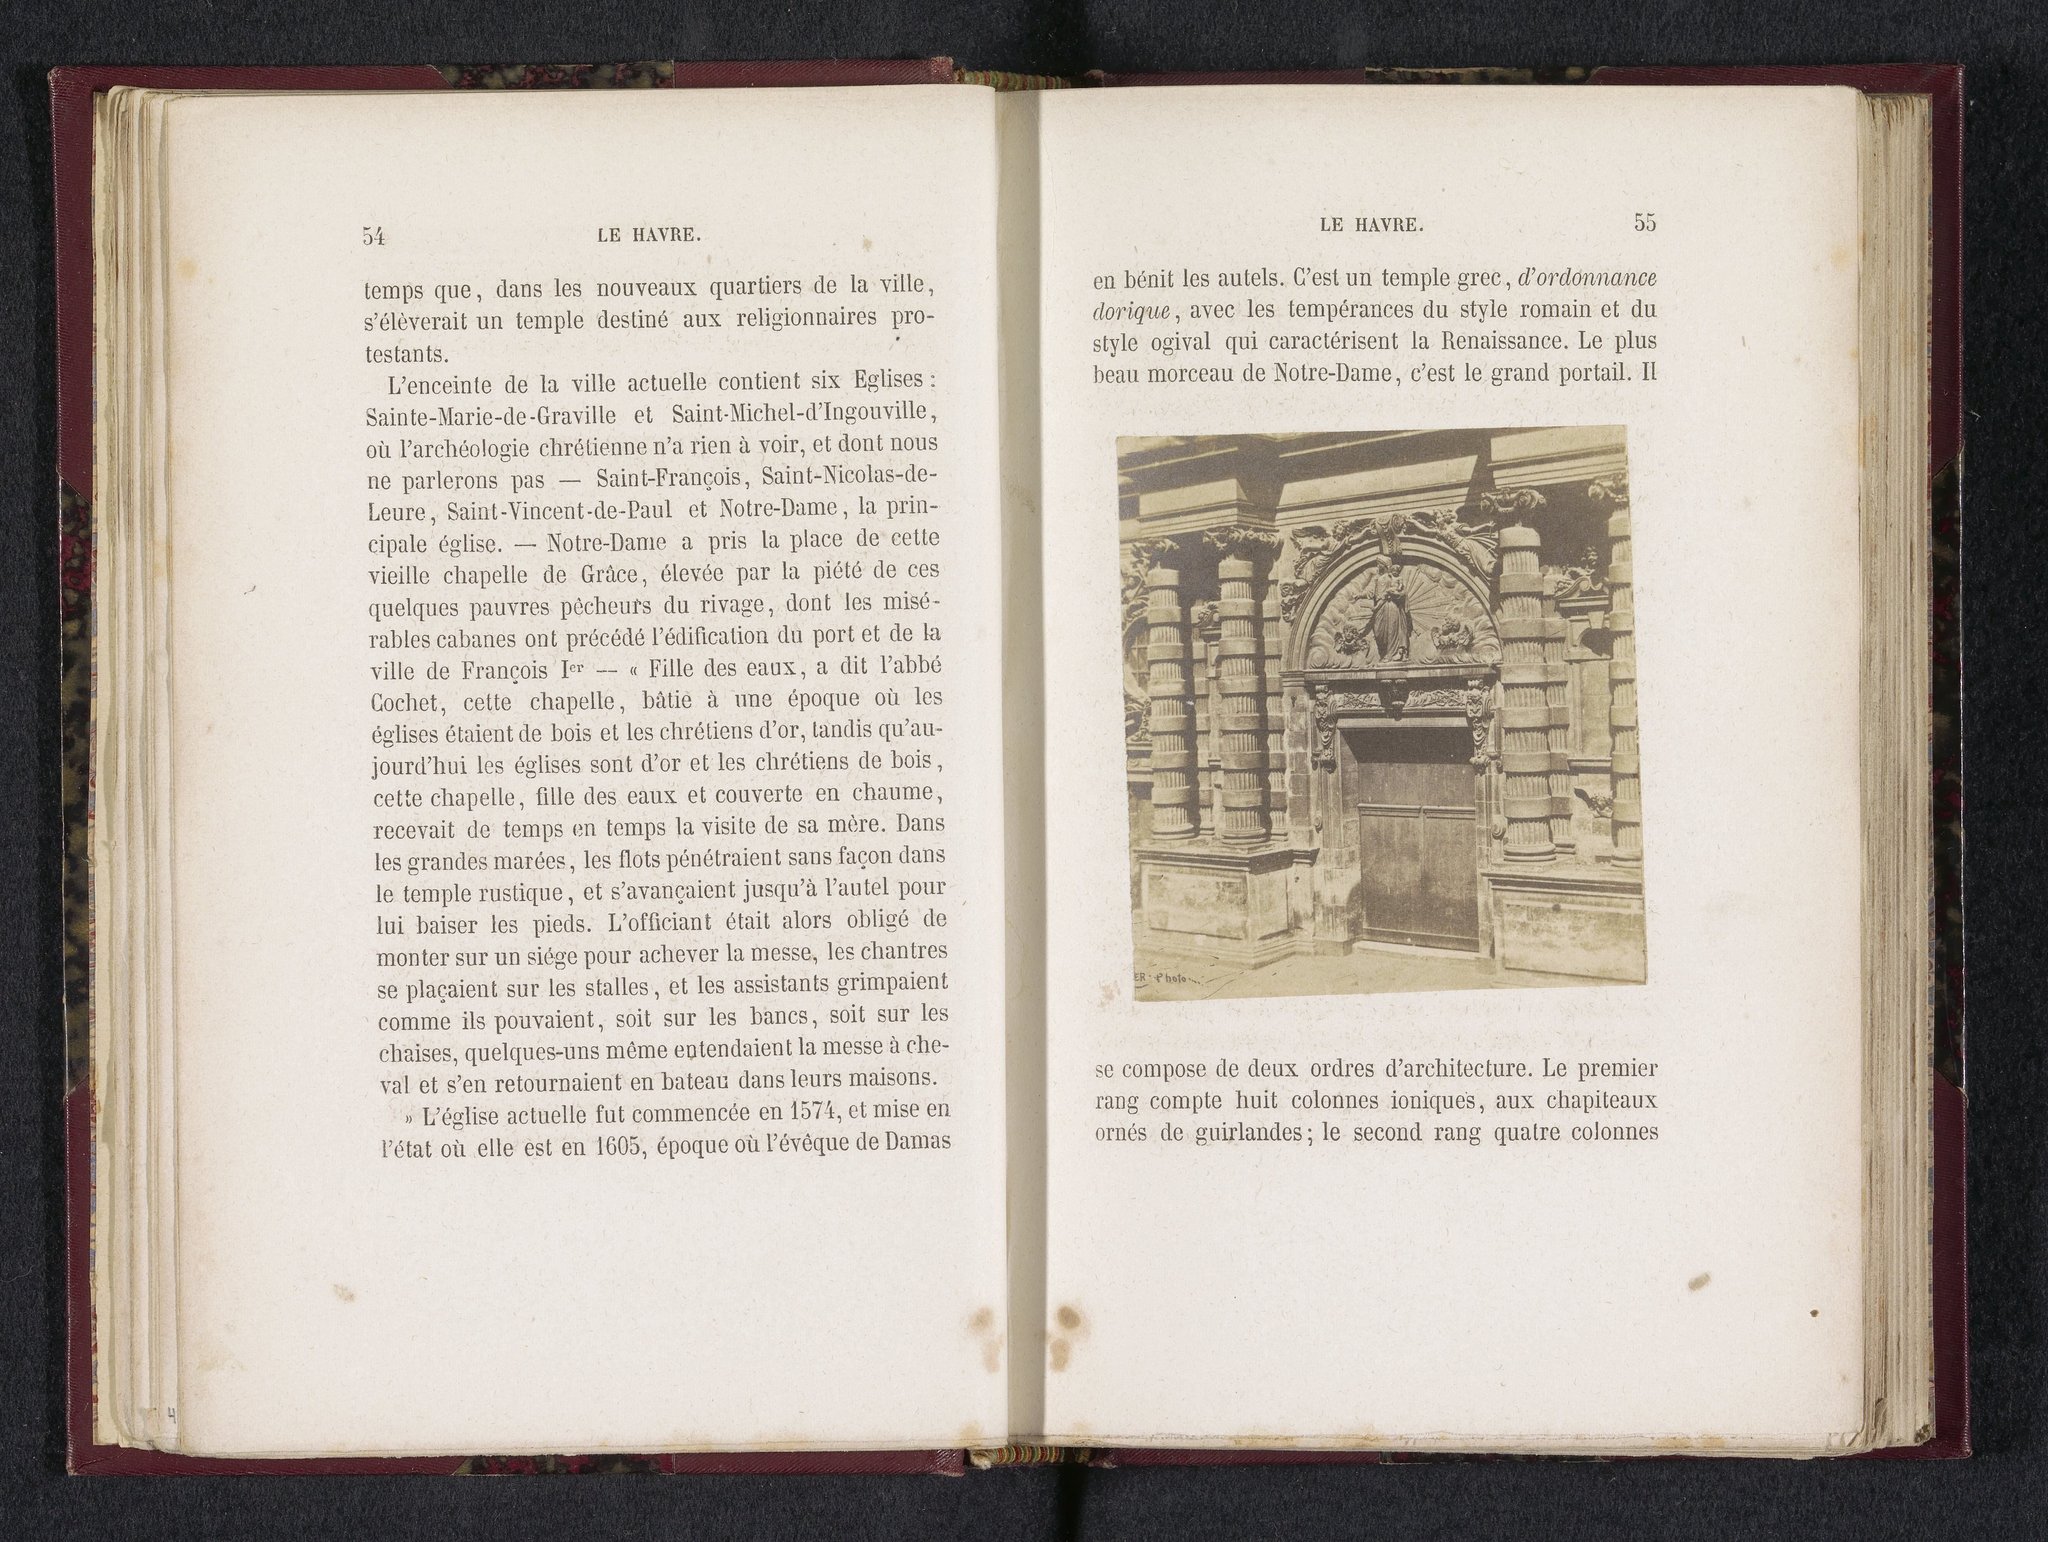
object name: page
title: Portaal van de Notre-Dame in Le Havre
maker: kaiser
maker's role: fotograaf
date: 1850-1860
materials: photographic support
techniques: salted paper print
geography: le havre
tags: parts of church exterior and annexes: porch, le havre